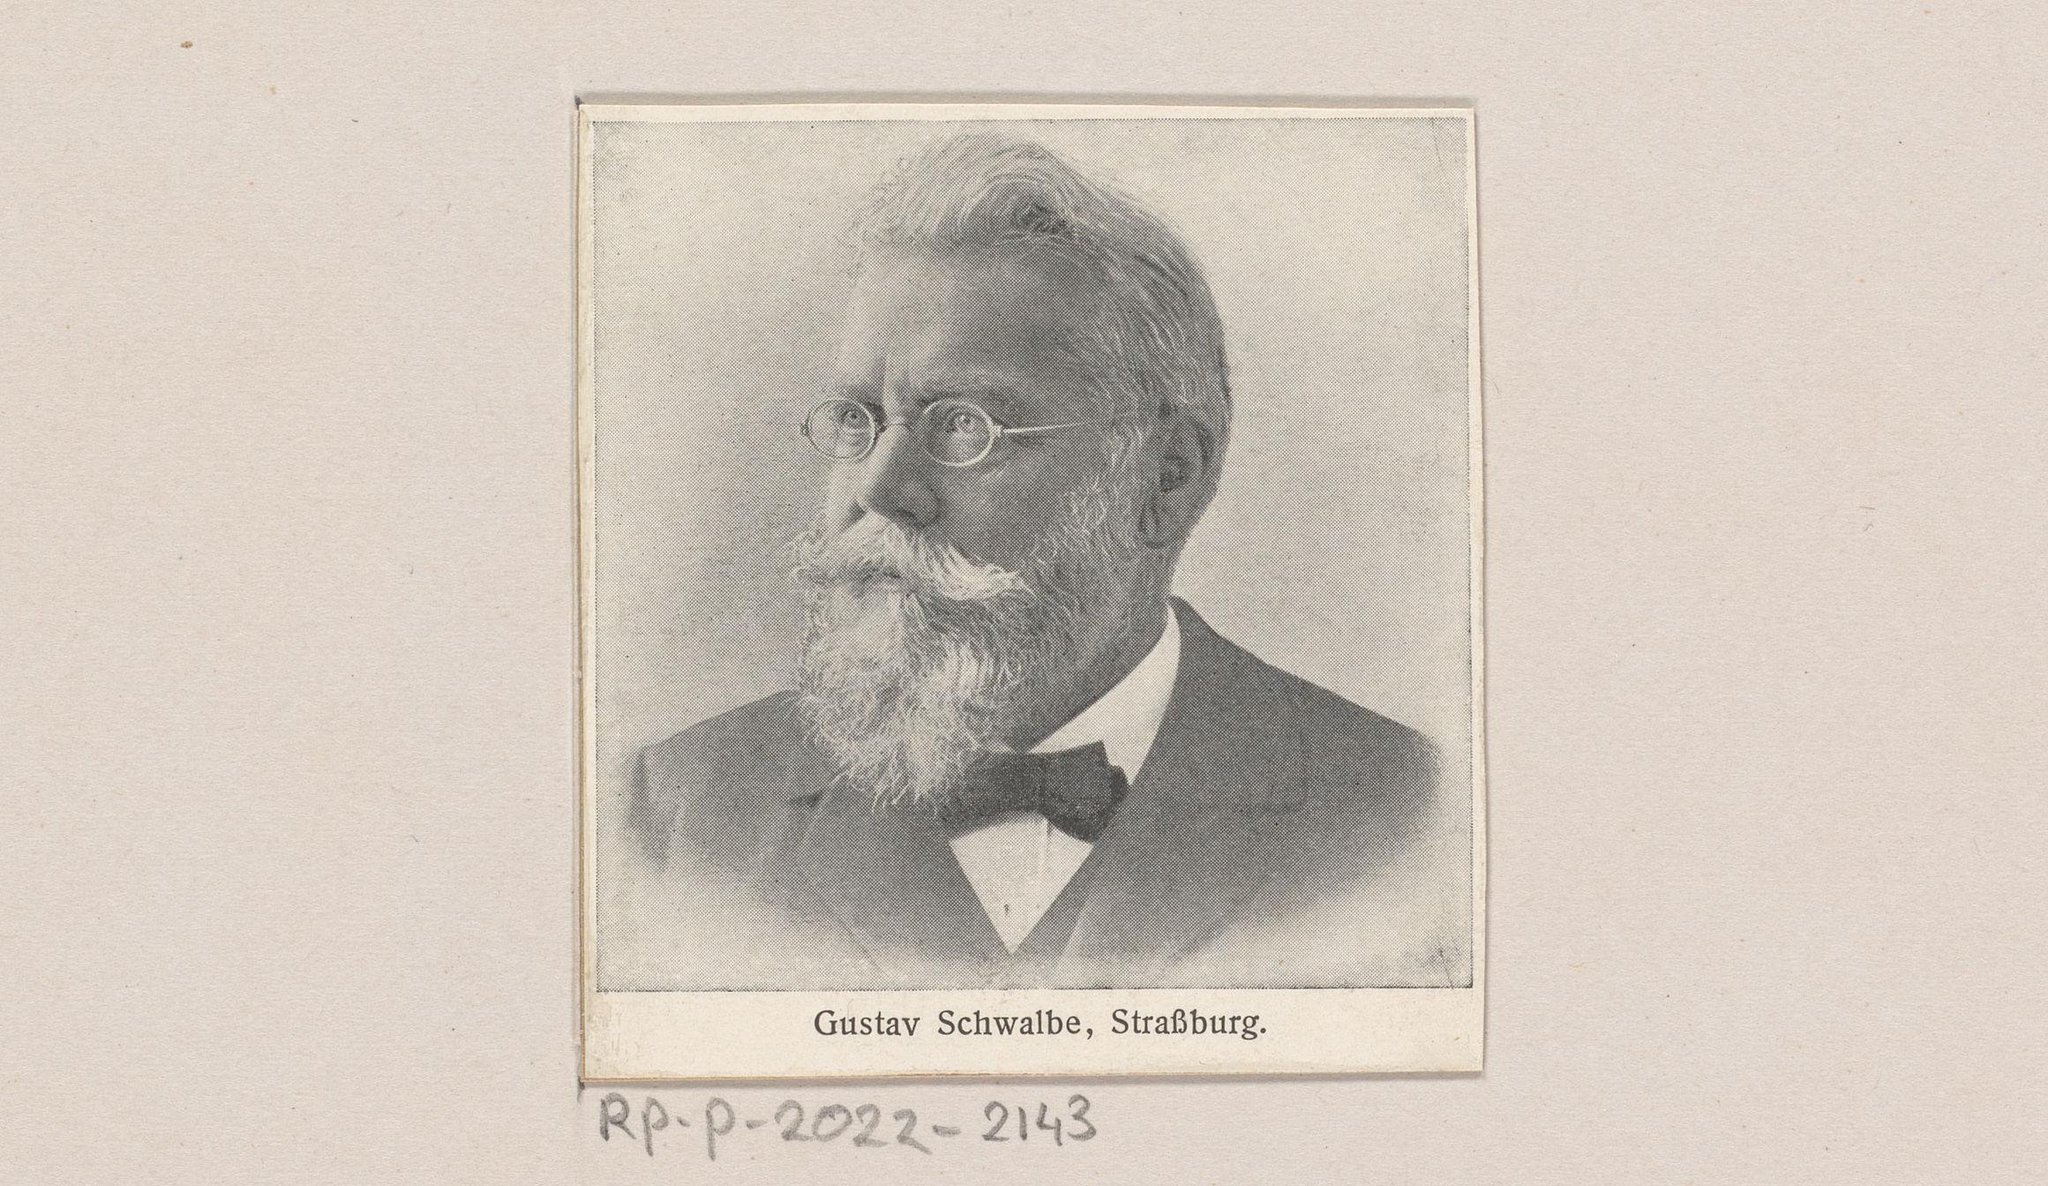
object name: photomechanical print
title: Portret van Gustav Albert Schwalbe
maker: Anonymous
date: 1883-1970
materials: paper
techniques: autotype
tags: ethnology, cultural anthropology (+ portrait of scholar, scientist), historical persons, physiology and anatomy (+ portrait of scholar, scientist)